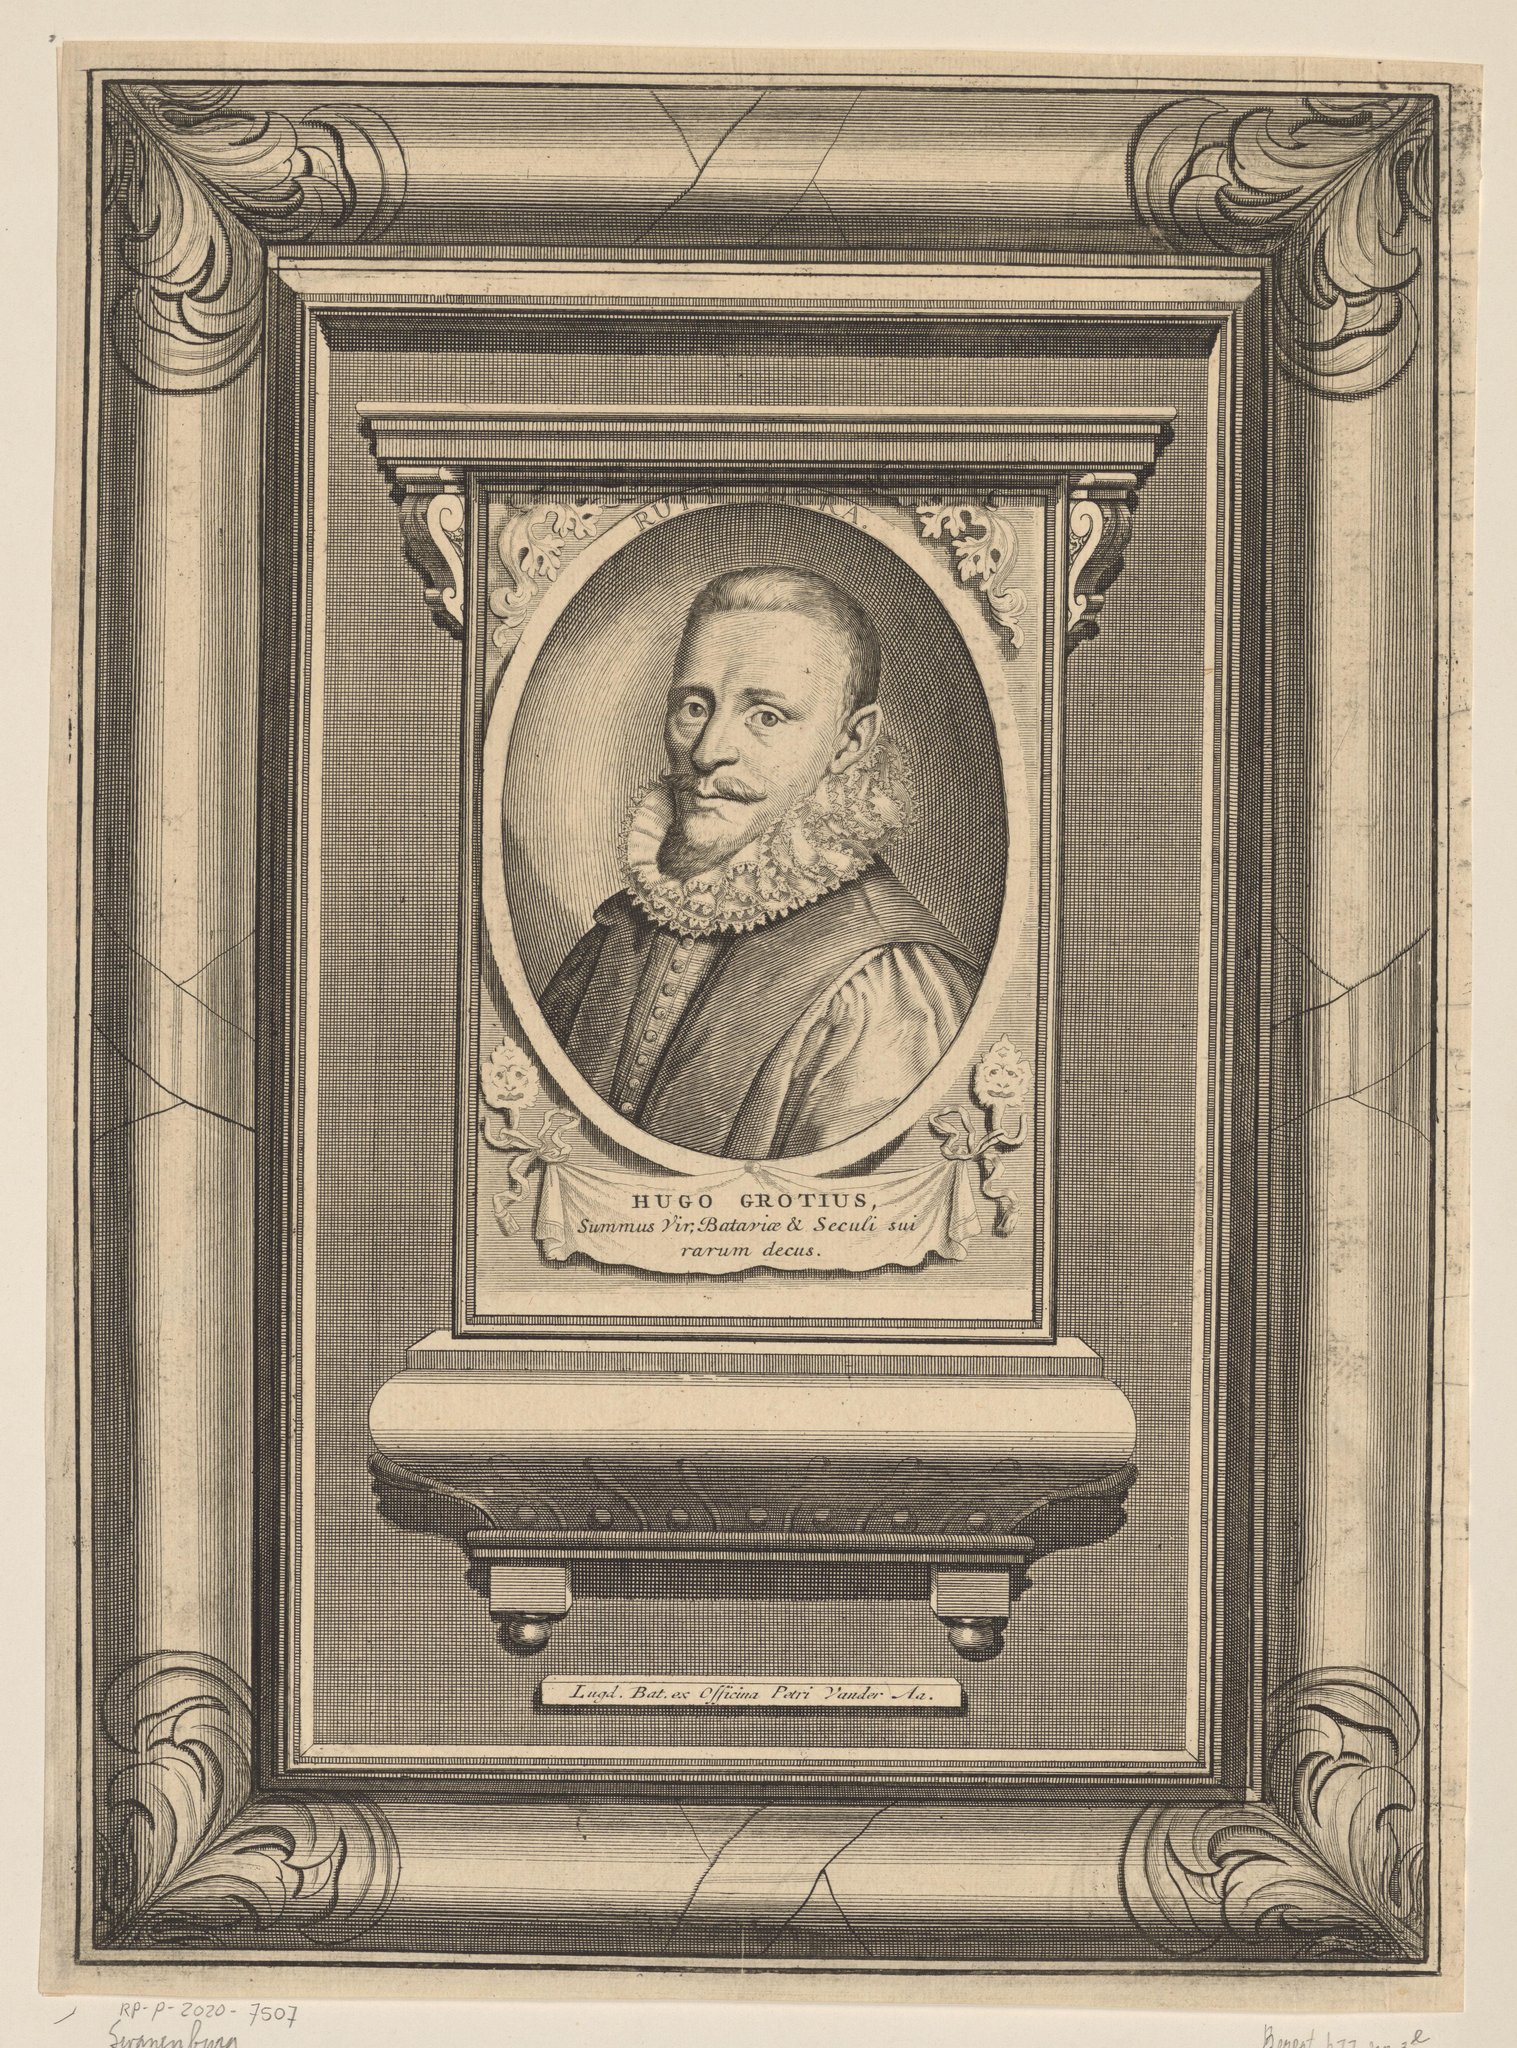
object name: print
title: Portret van Hugo de Groot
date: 1668-1716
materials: paper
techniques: engraving, etching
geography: leiden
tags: delft, hugo de groot, theologian, historical persons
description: Eerdere staat gebruikt in: Meursius, Joannes. Illustris Academia Lugd.-Batava. Leiden: Andries Clouck, 1613. Prent waarschijnlijk gebruikt in: Fundatoris, Curatorum et Professorum celeberrimorum aliorumque illustrium virorum, quorum gratia, favore, cura, doctrinaque Academia Lugduno-Batava incepit, auctaque et ornata est, effigies. Nec non urbis, Academiae ejusque Horti, Templorum notabiliorumque publicorum aedificiorum prospectus. Leiden: Pieter van der Aa (I), [1716].